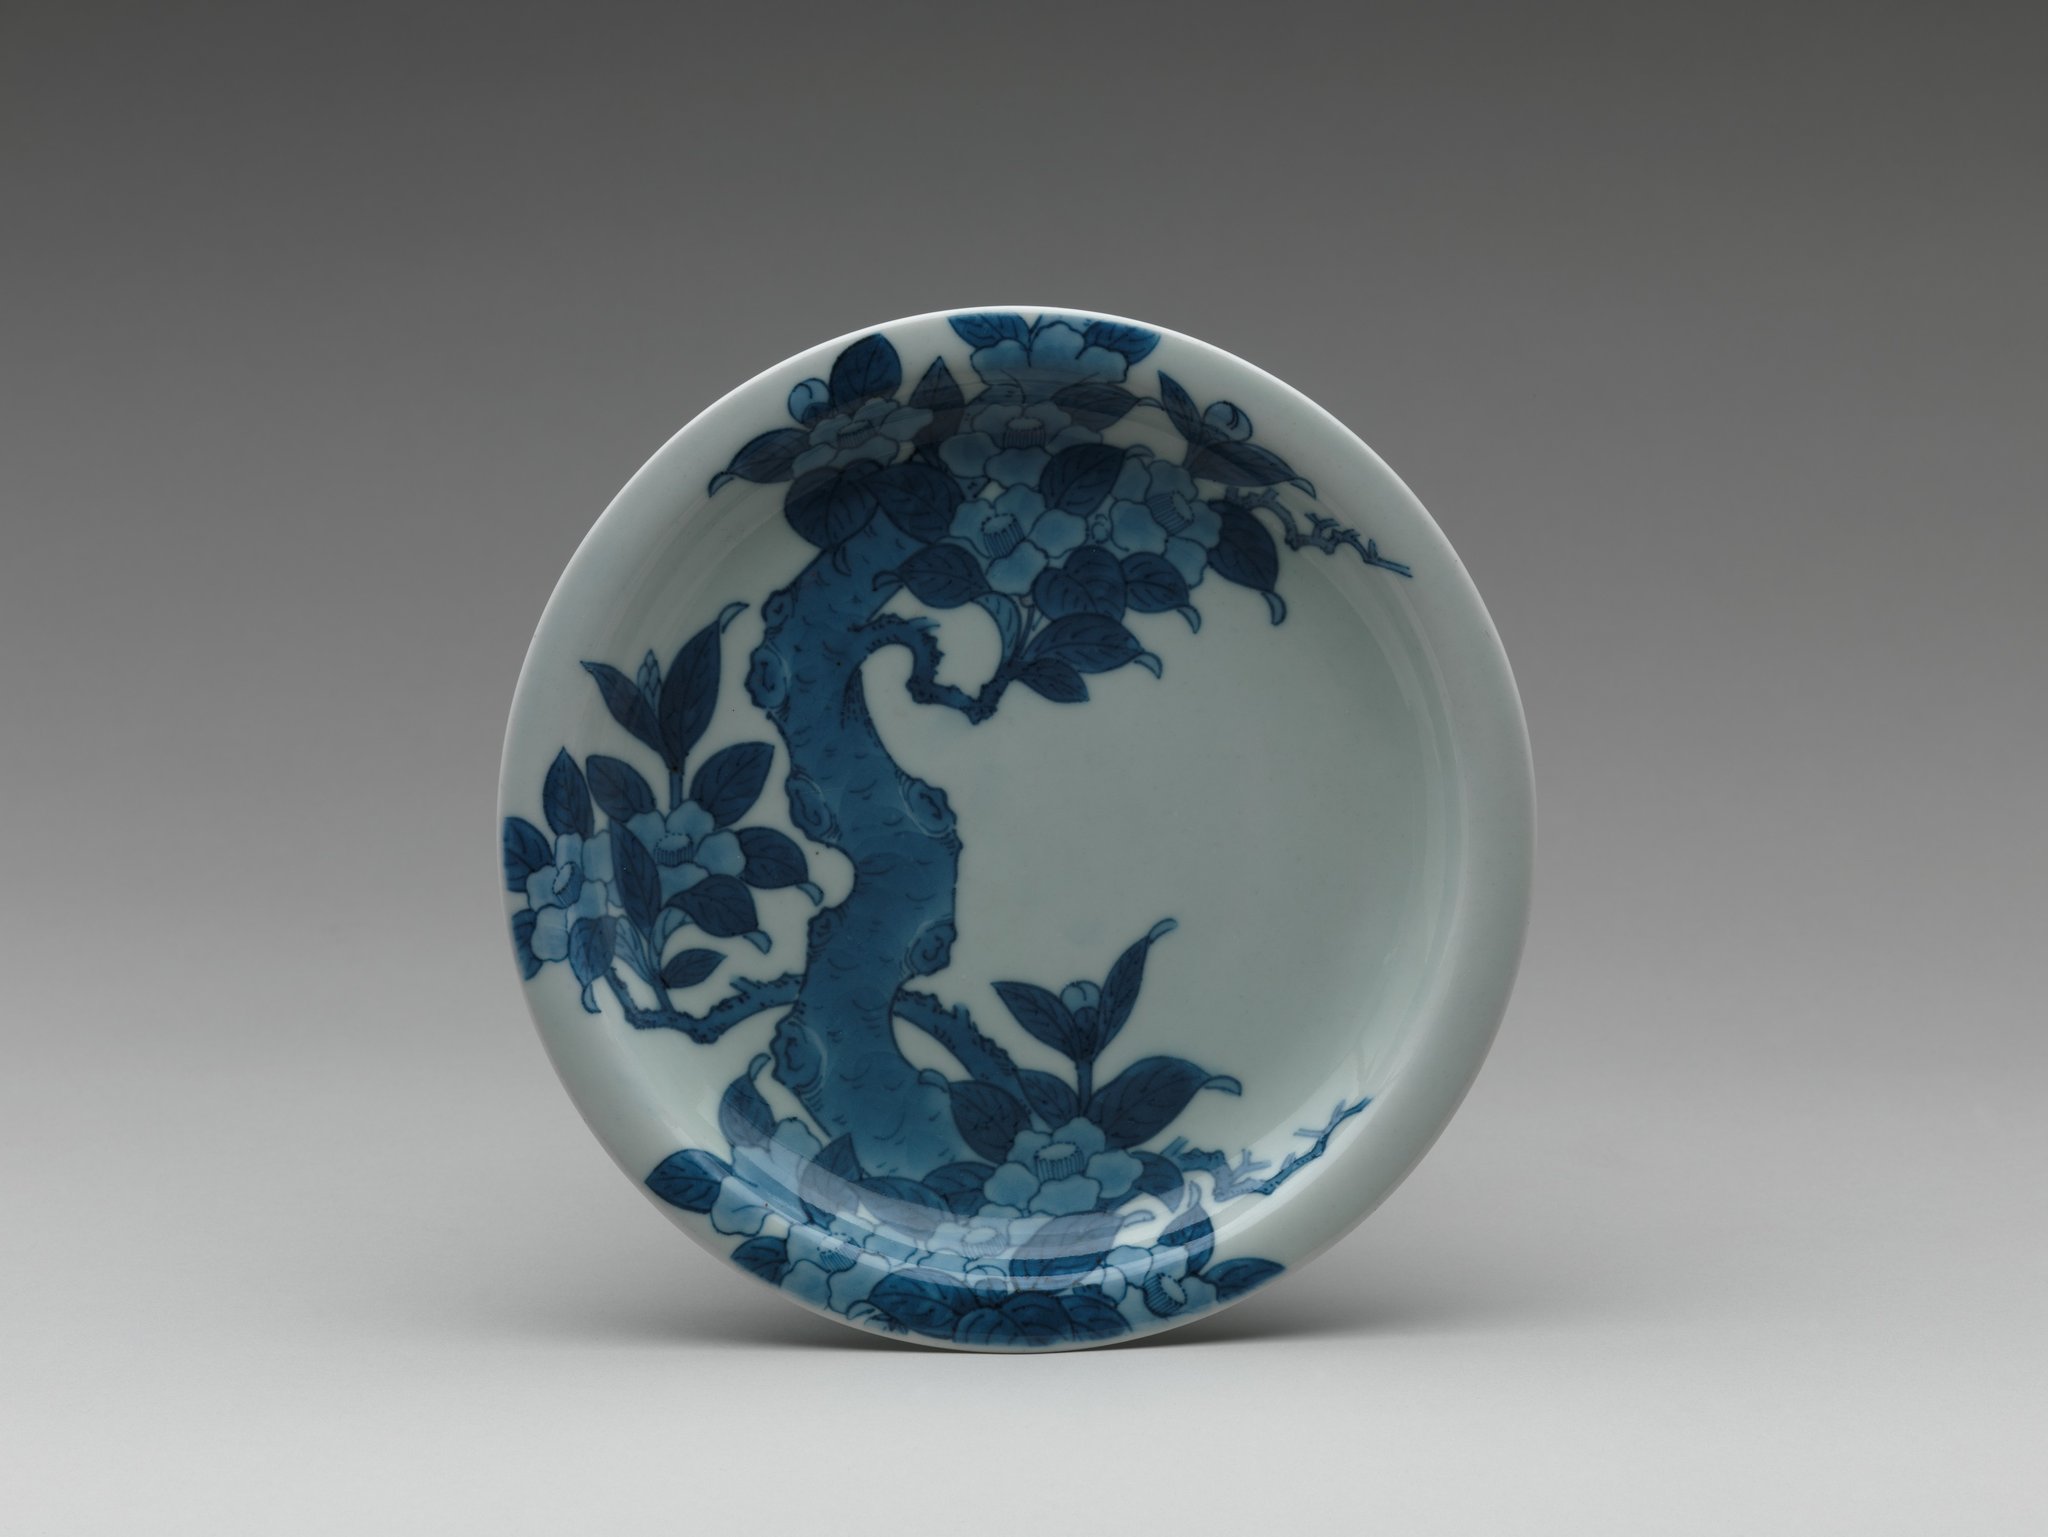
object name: dish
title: Dish with Camellias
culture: japanese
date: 1901-1933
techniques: underglaze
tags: flowers